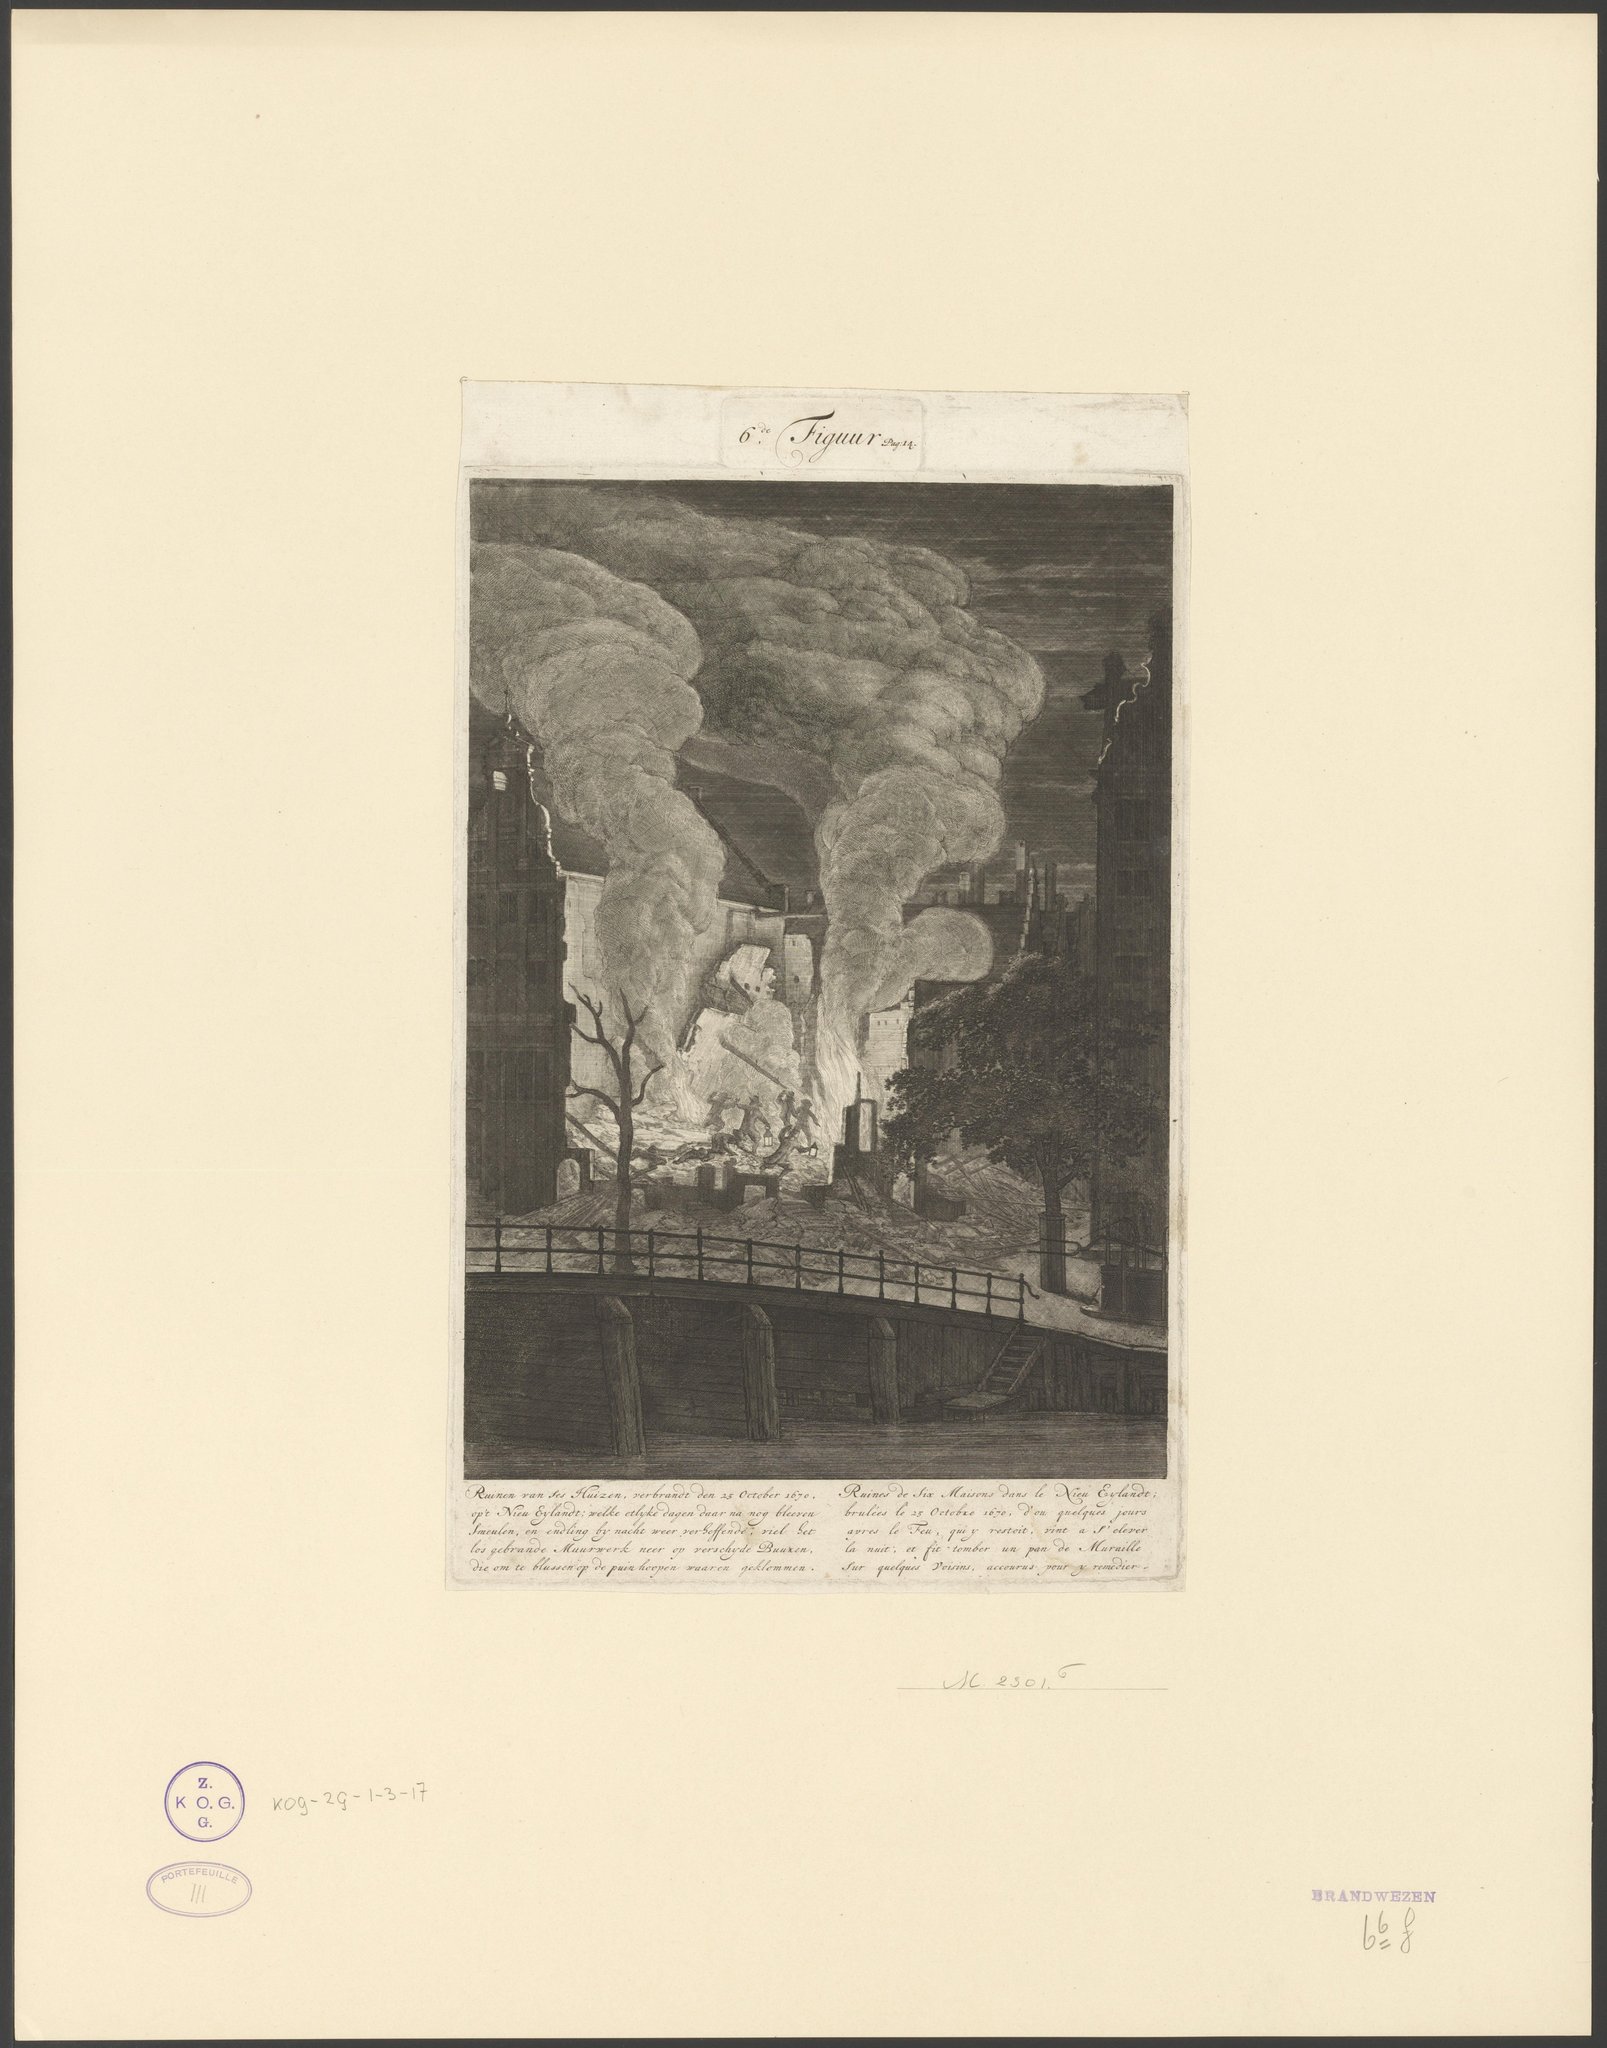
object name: book illustration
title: Brand op het Waalseiland te Amsterdam, 1670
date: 1735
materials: paper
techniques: engraving, etching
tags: on fire, ablaze, collapsing building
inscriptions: stamp, stamp, collector's mark: Lugt 1641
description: De nog brandende ruïnes van zes huizen bij de brand van 25 oktober 1670 aan de Binnenkant bij de hoek van de Buiten Bantammerstraat op het Waalseiland (ook bekend als het Nieuwe Eiland) te Amsterdam. Met vijfregelig onderschrift in het Nederlands en Bovenaan de tekst: 6de Figuur Pag: 14. Onderwerpsrubrieken binnen de Atlas Zeden en Gewoonten: Regeering, Brandwezen.